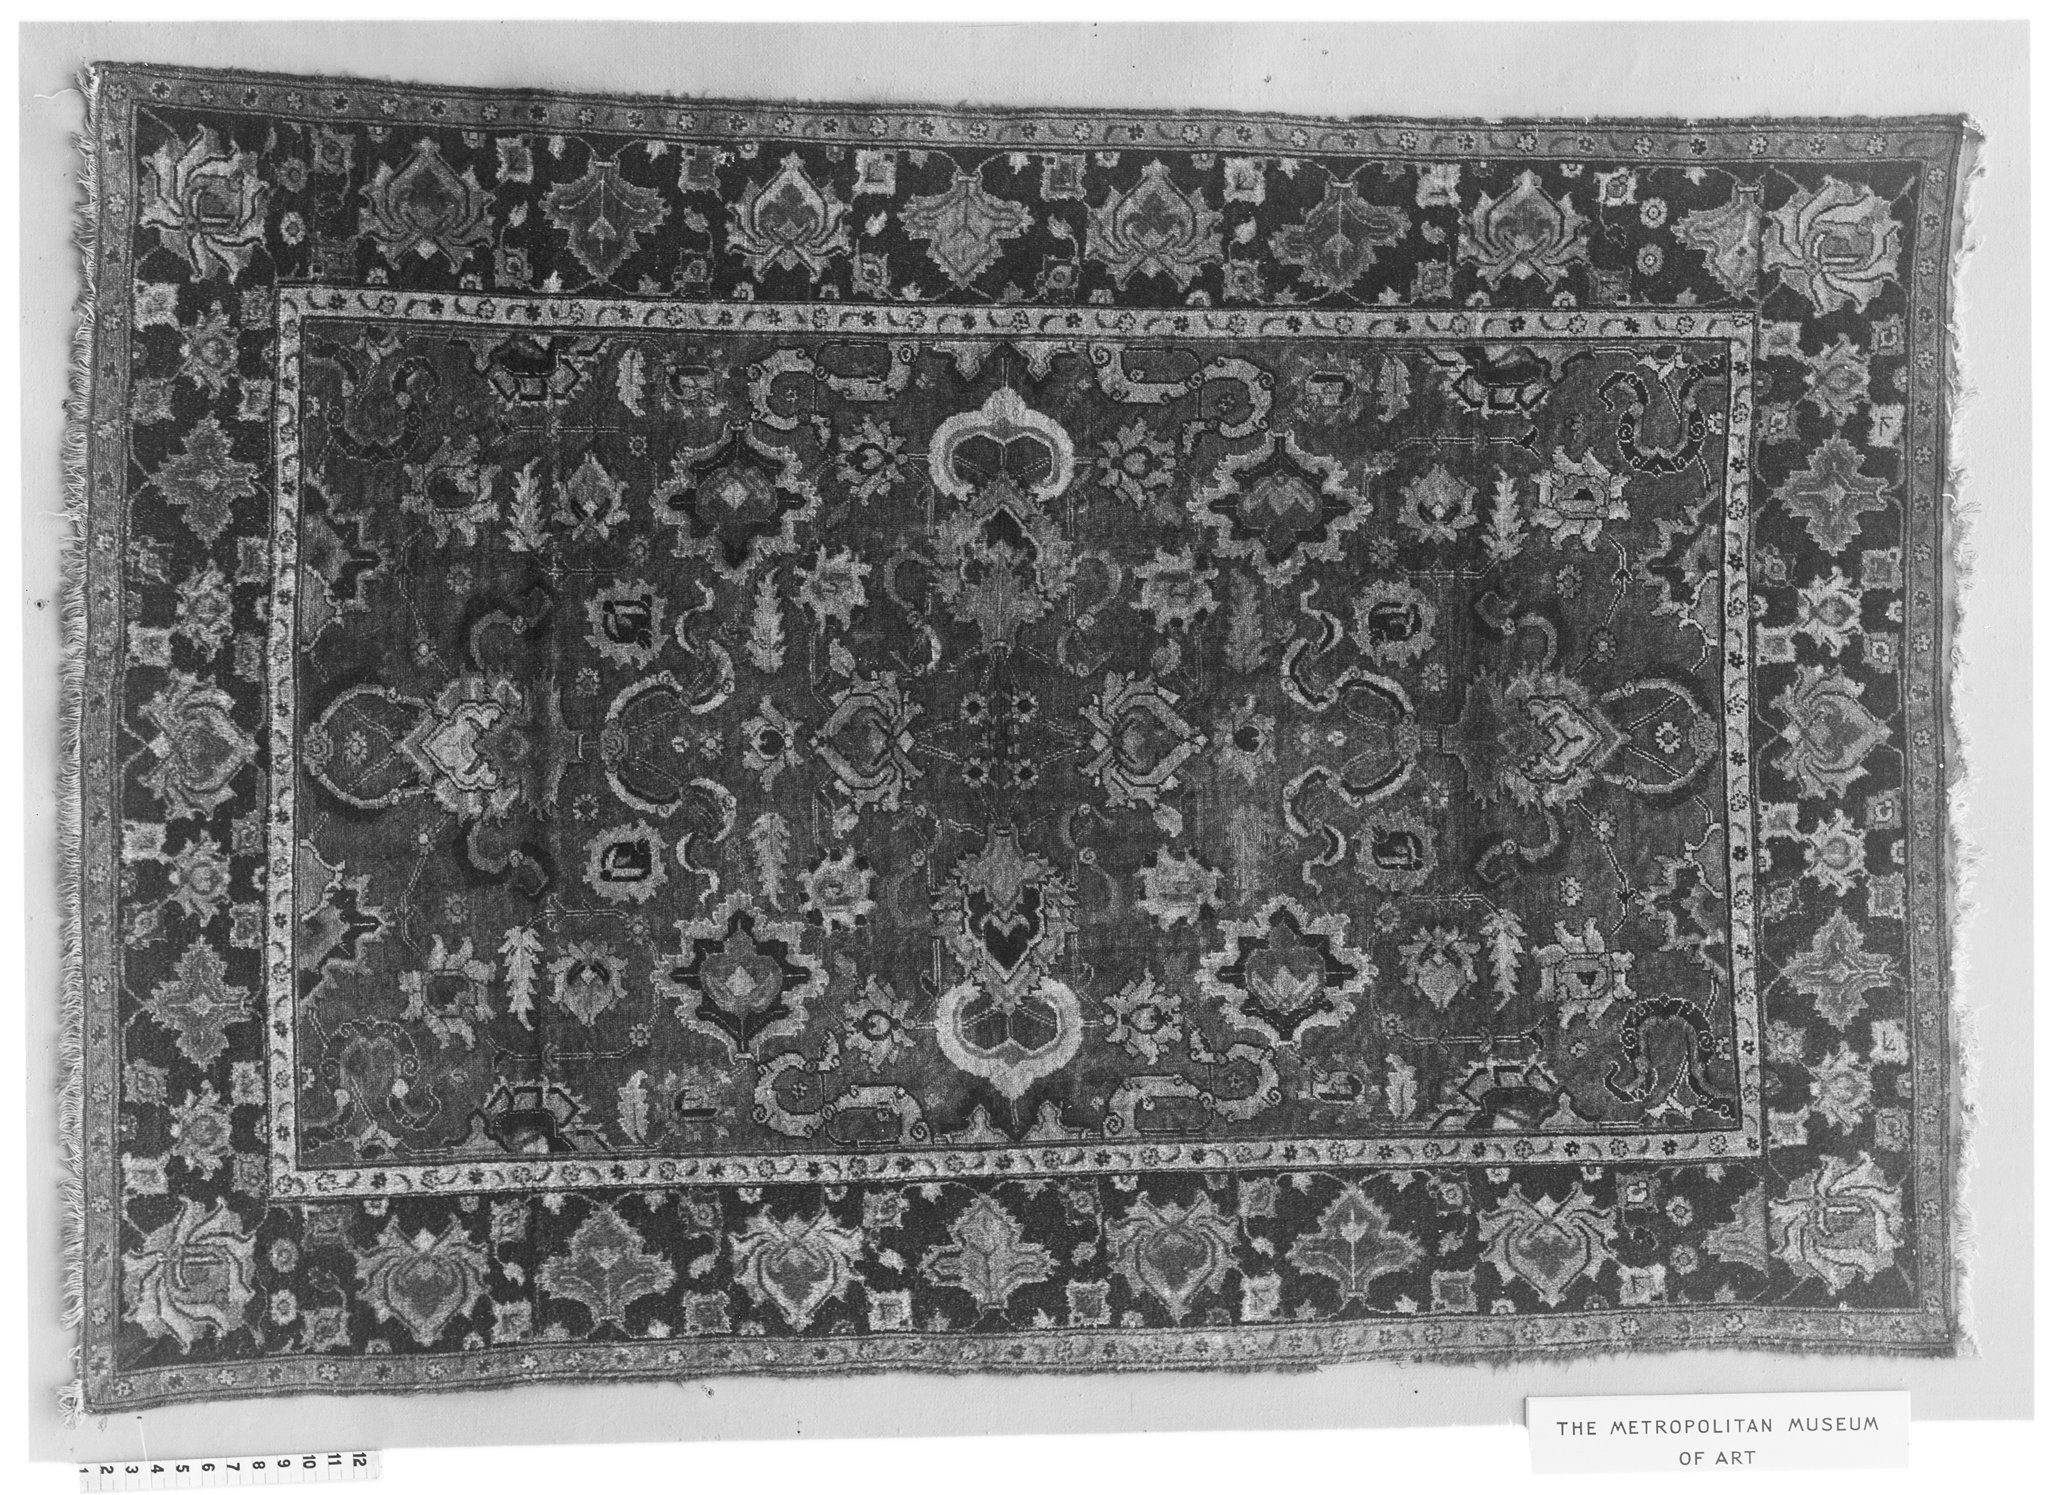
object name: carpet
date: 1601-1700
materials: cotton, wool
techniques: pile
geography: iran